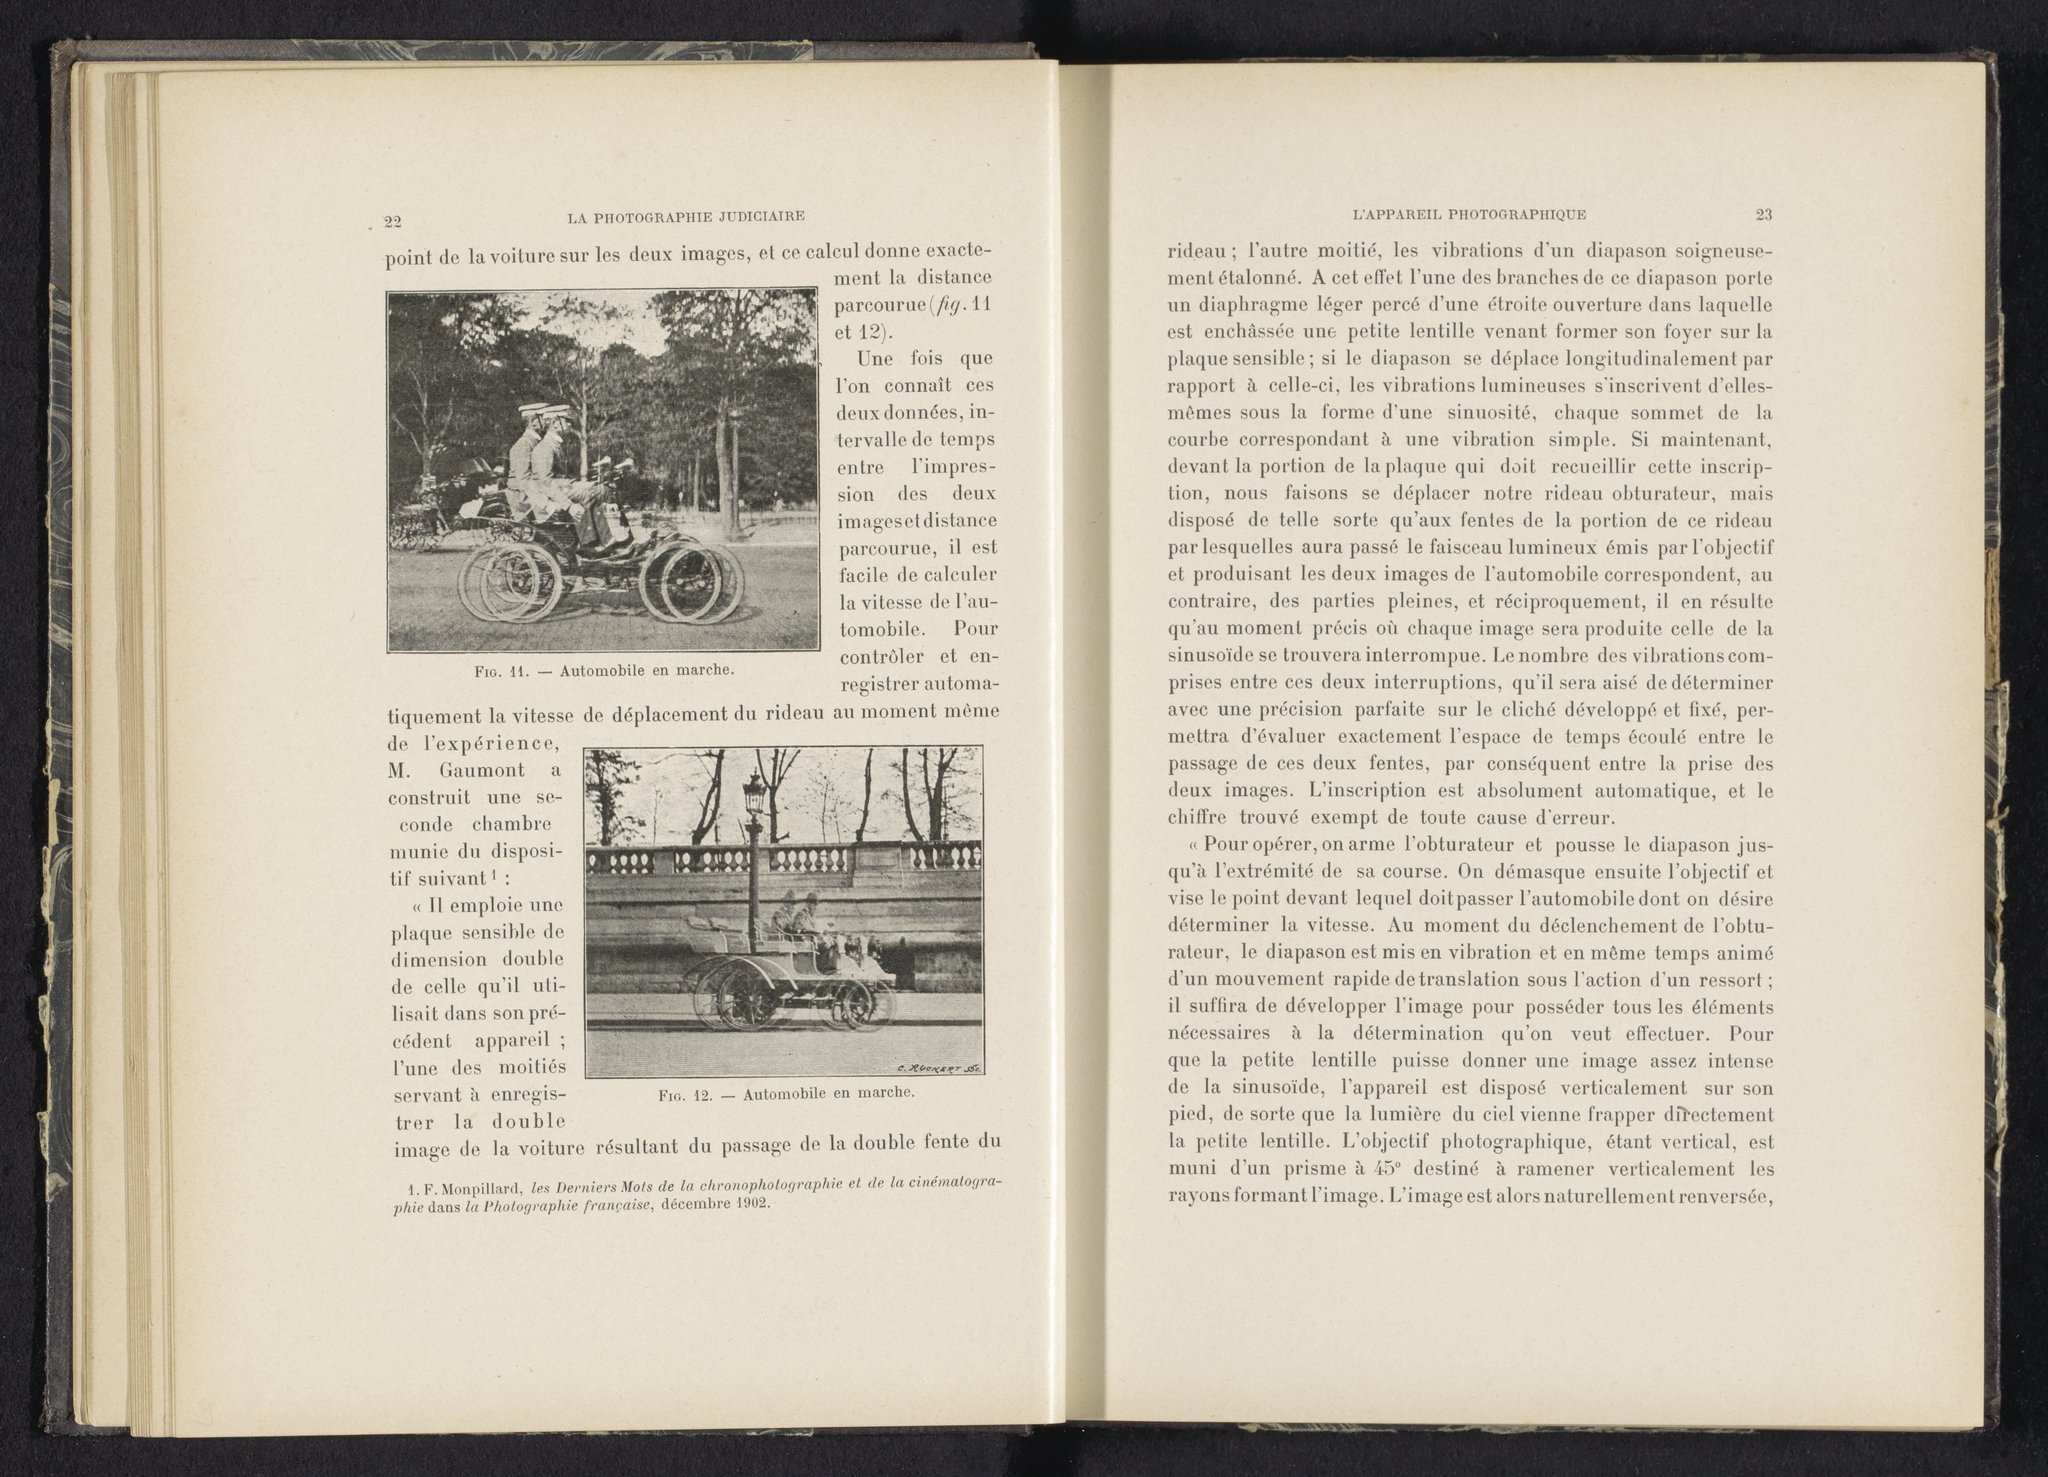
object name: page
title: Automobielen in beweging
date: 1893-1903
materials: paper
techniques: autotype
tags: automobile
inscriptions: number: ‘Fig. 11. Fig. 12.’